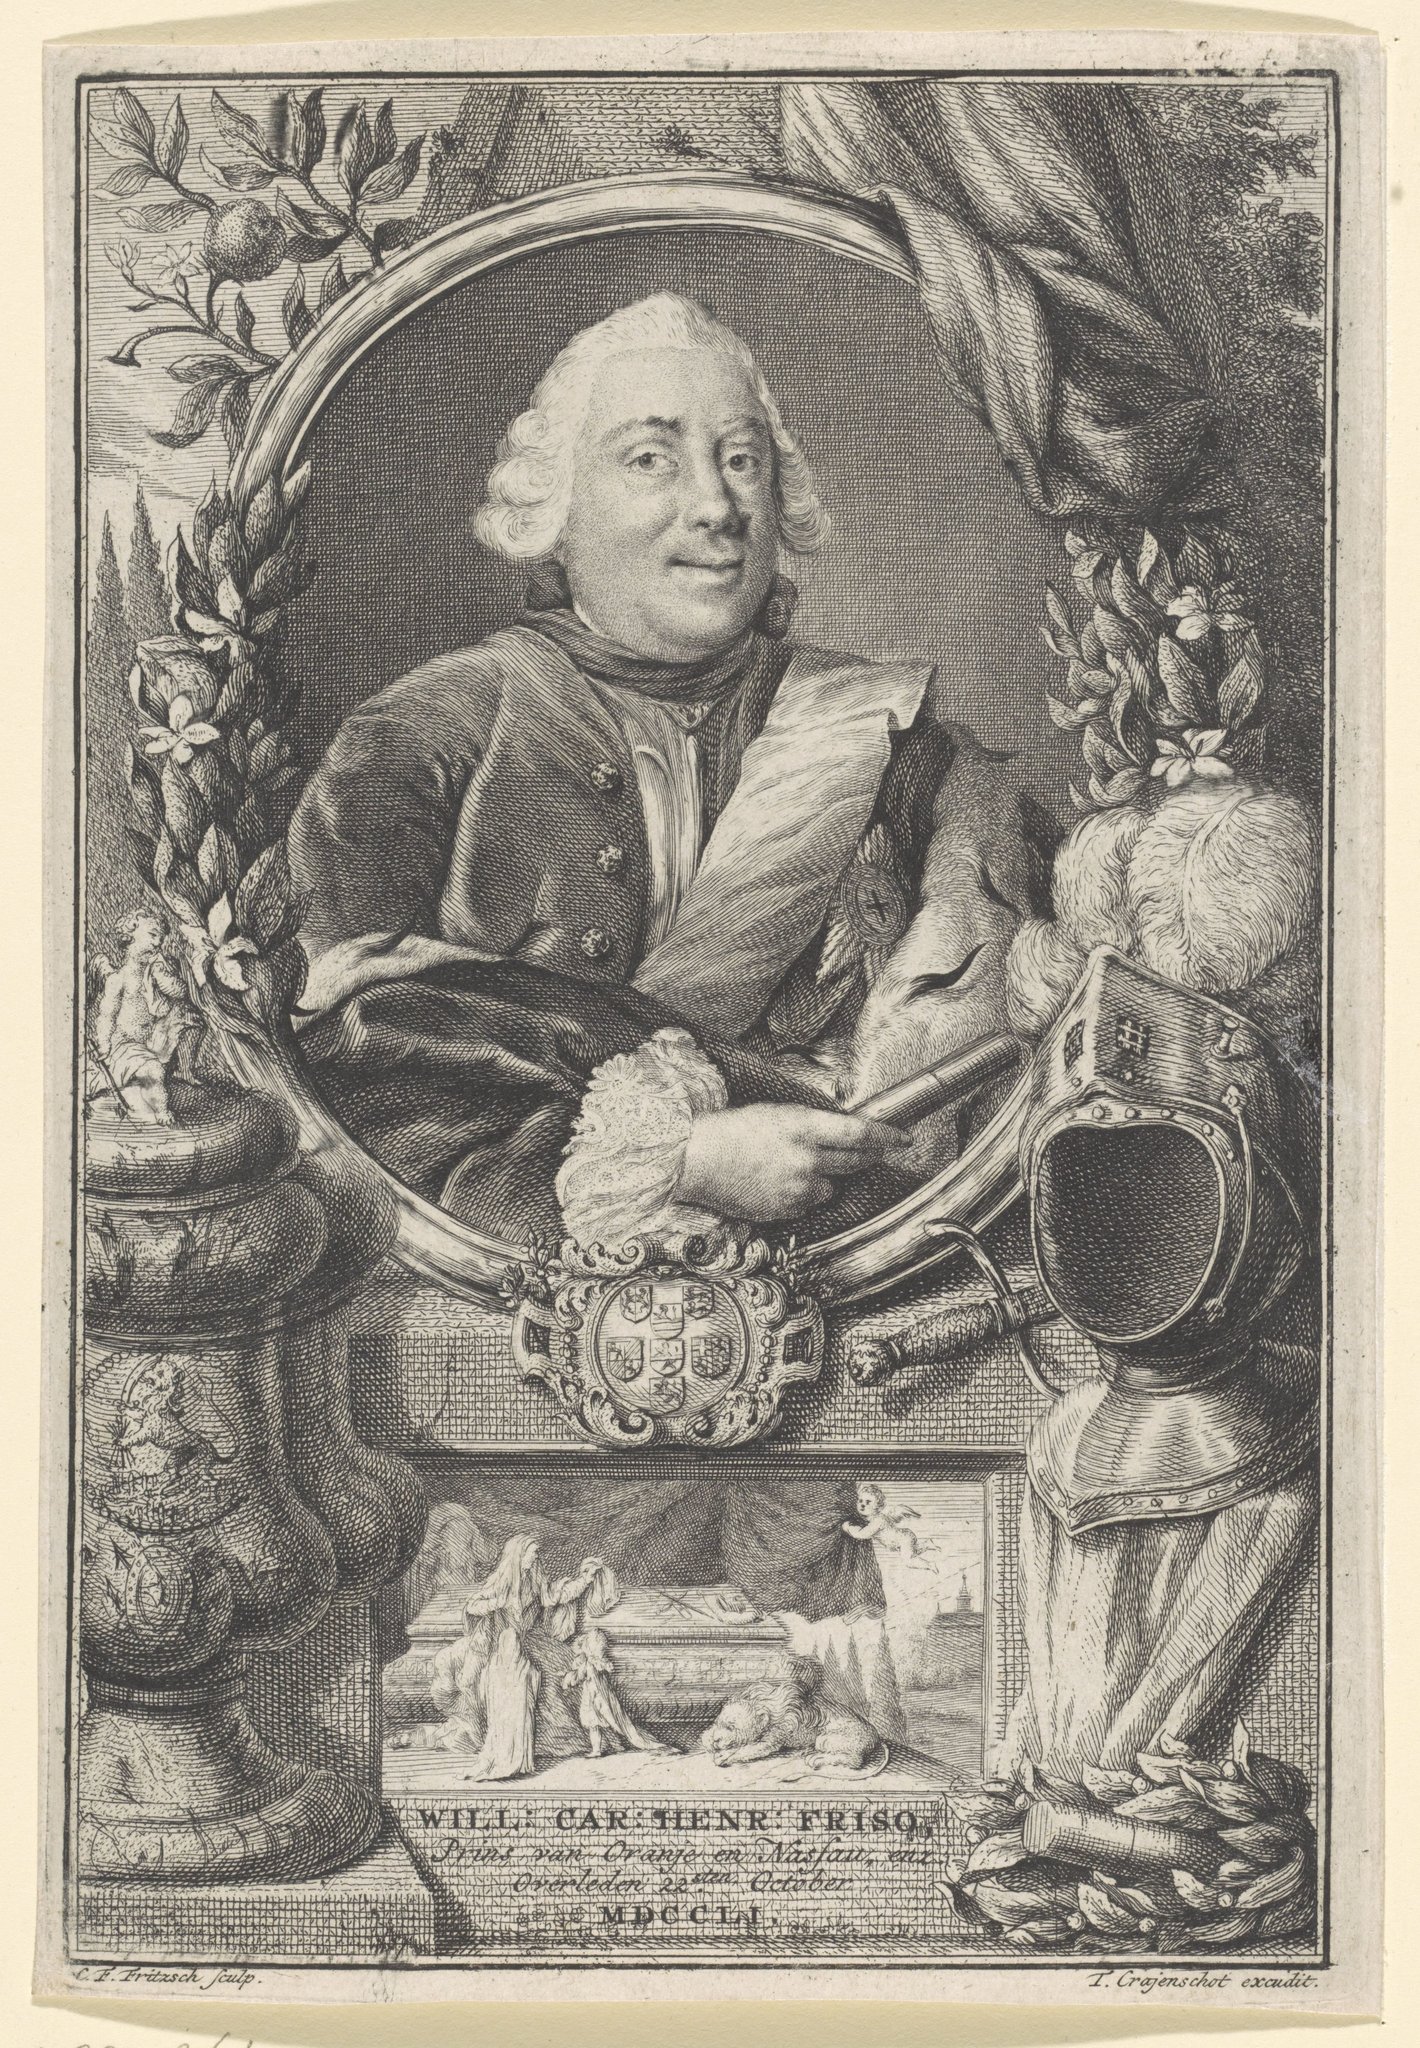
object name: print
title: Portret van Willem IV, prins van Oranje-Nassau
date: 1751-1803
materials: paper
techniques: engraving, etching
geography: amsterdam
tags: willem iv (prins van oranje-nassau)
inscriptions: collector's mark: Lugt 2228, collector's mark: Lugt 2760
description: Portret van Willem IV in een ovaal. In zijn rechterhand een commandostaf. Daar omheen een aantal allegorische objecten, waaronder een helm en oranjetakken. Op een voetstuk een voorstelling van zijn overlijden en vier regels Nederlandse tekst. Rechtsboven 'Pag: 49.'.